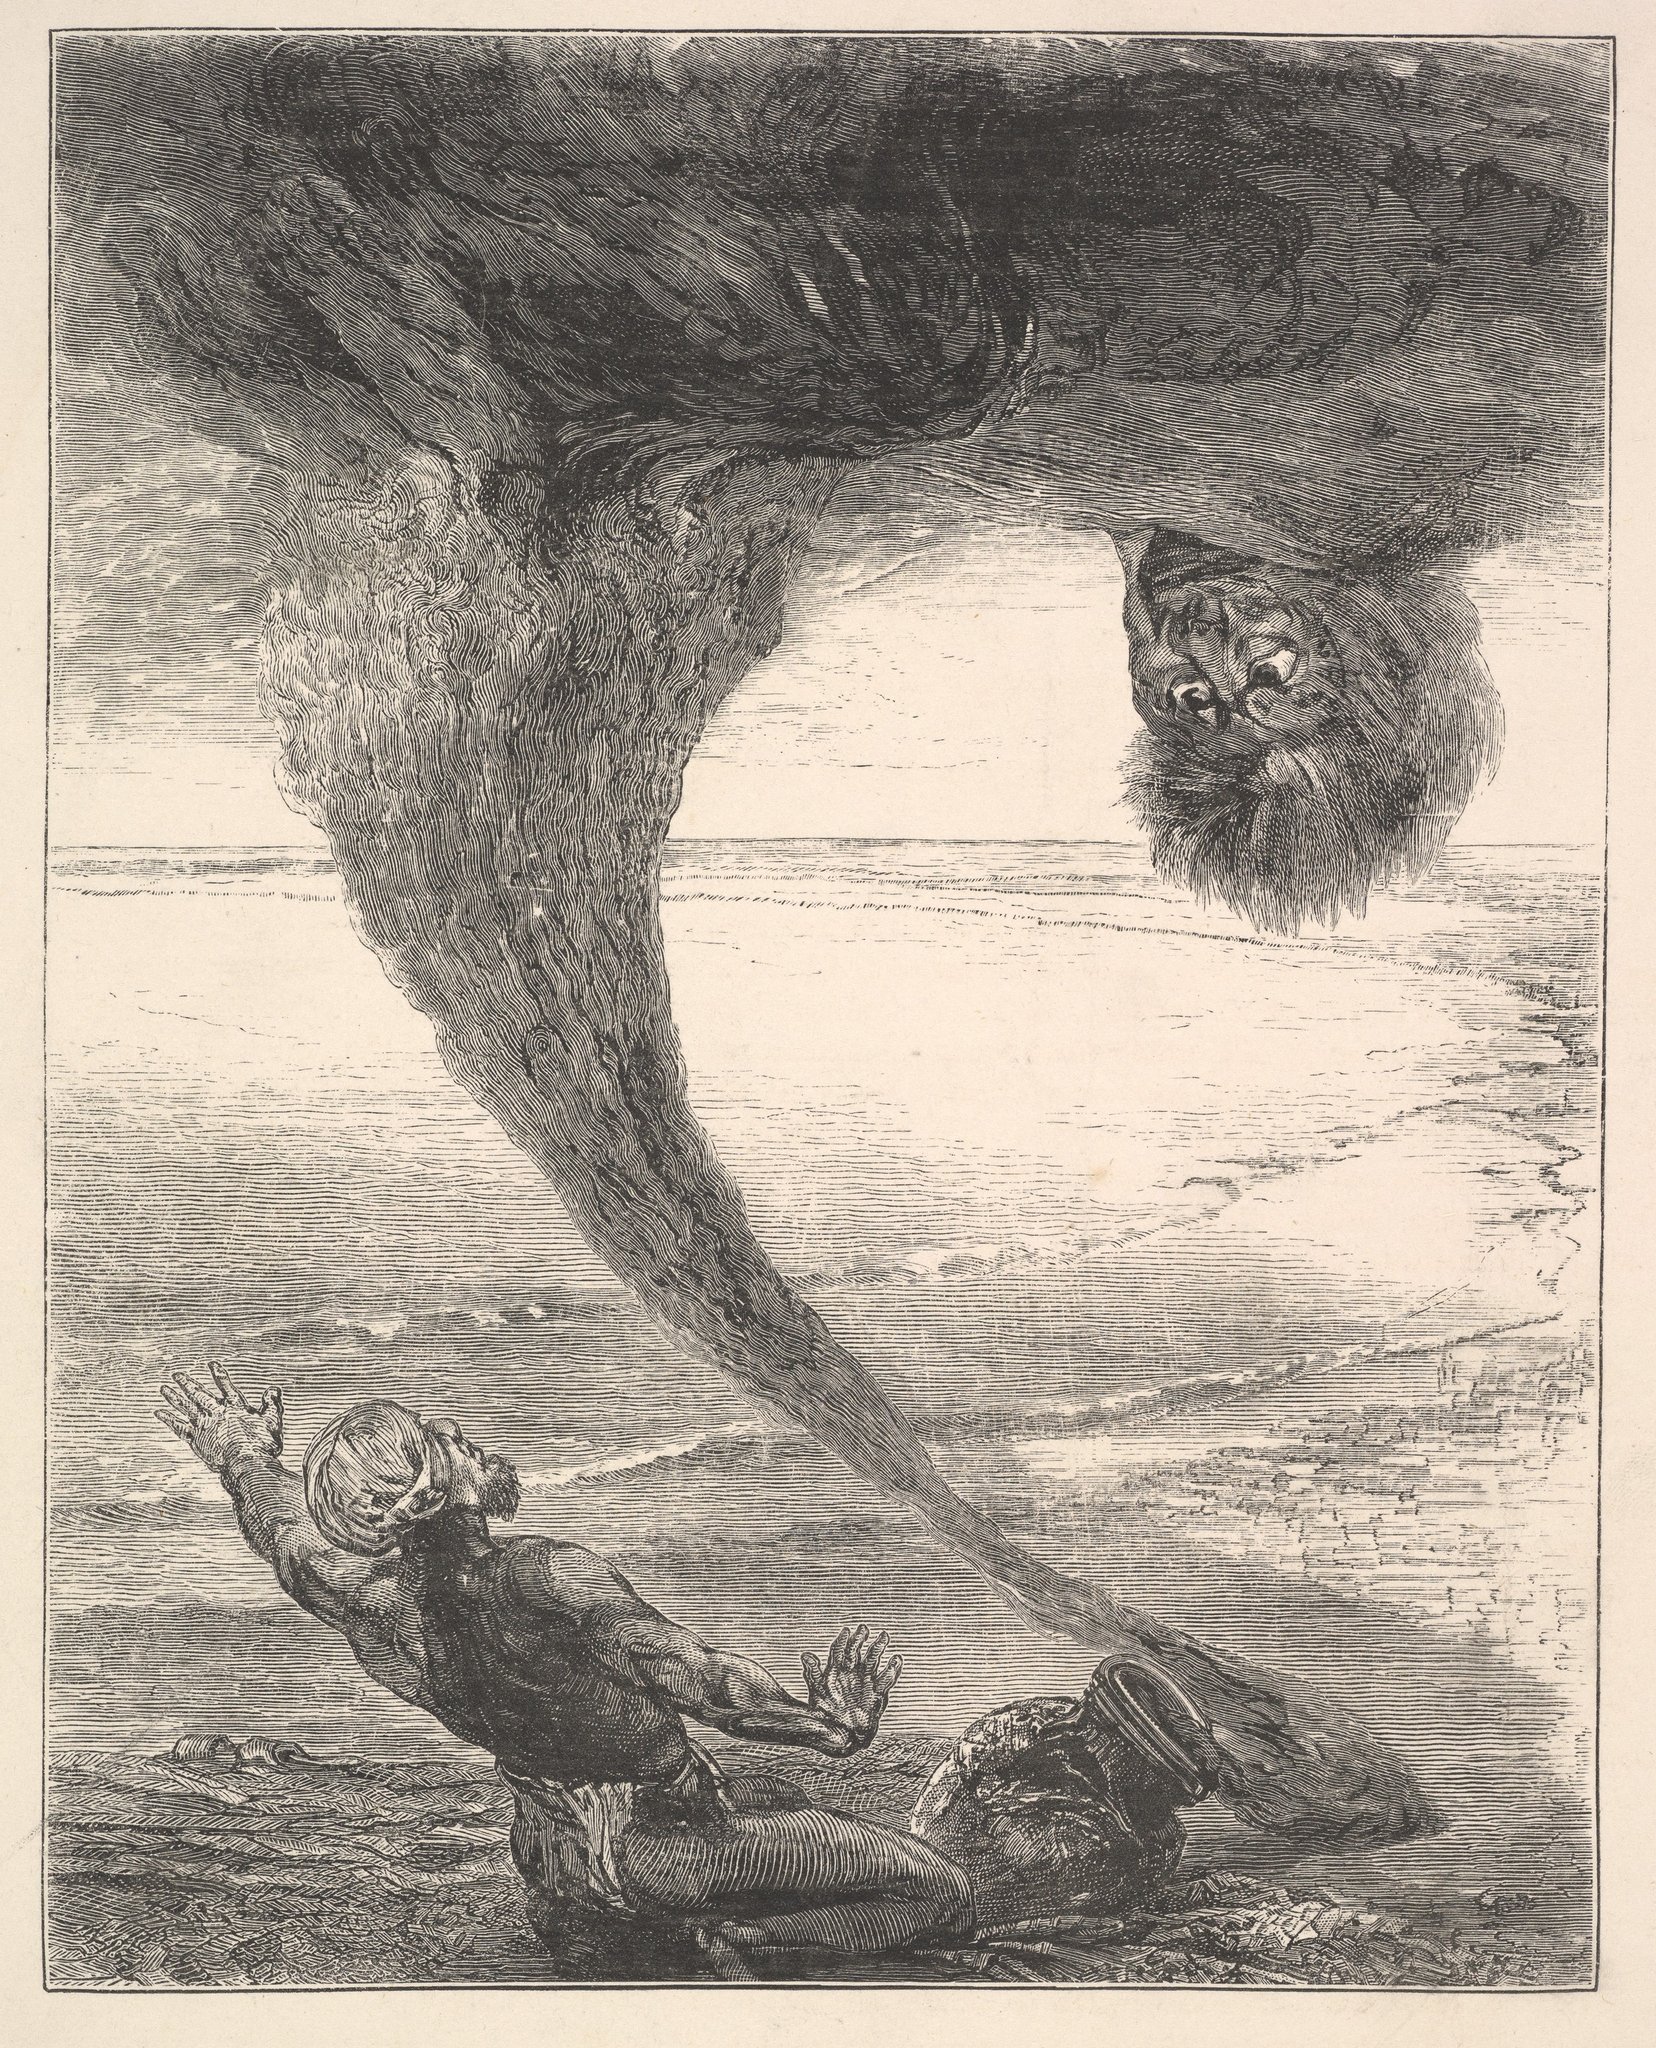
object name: print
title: The Fisherman and the Afrite (or Genie)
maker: john la farge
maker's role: artist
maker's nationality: american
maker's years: 1835-1910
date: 1868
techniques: engraving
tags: men